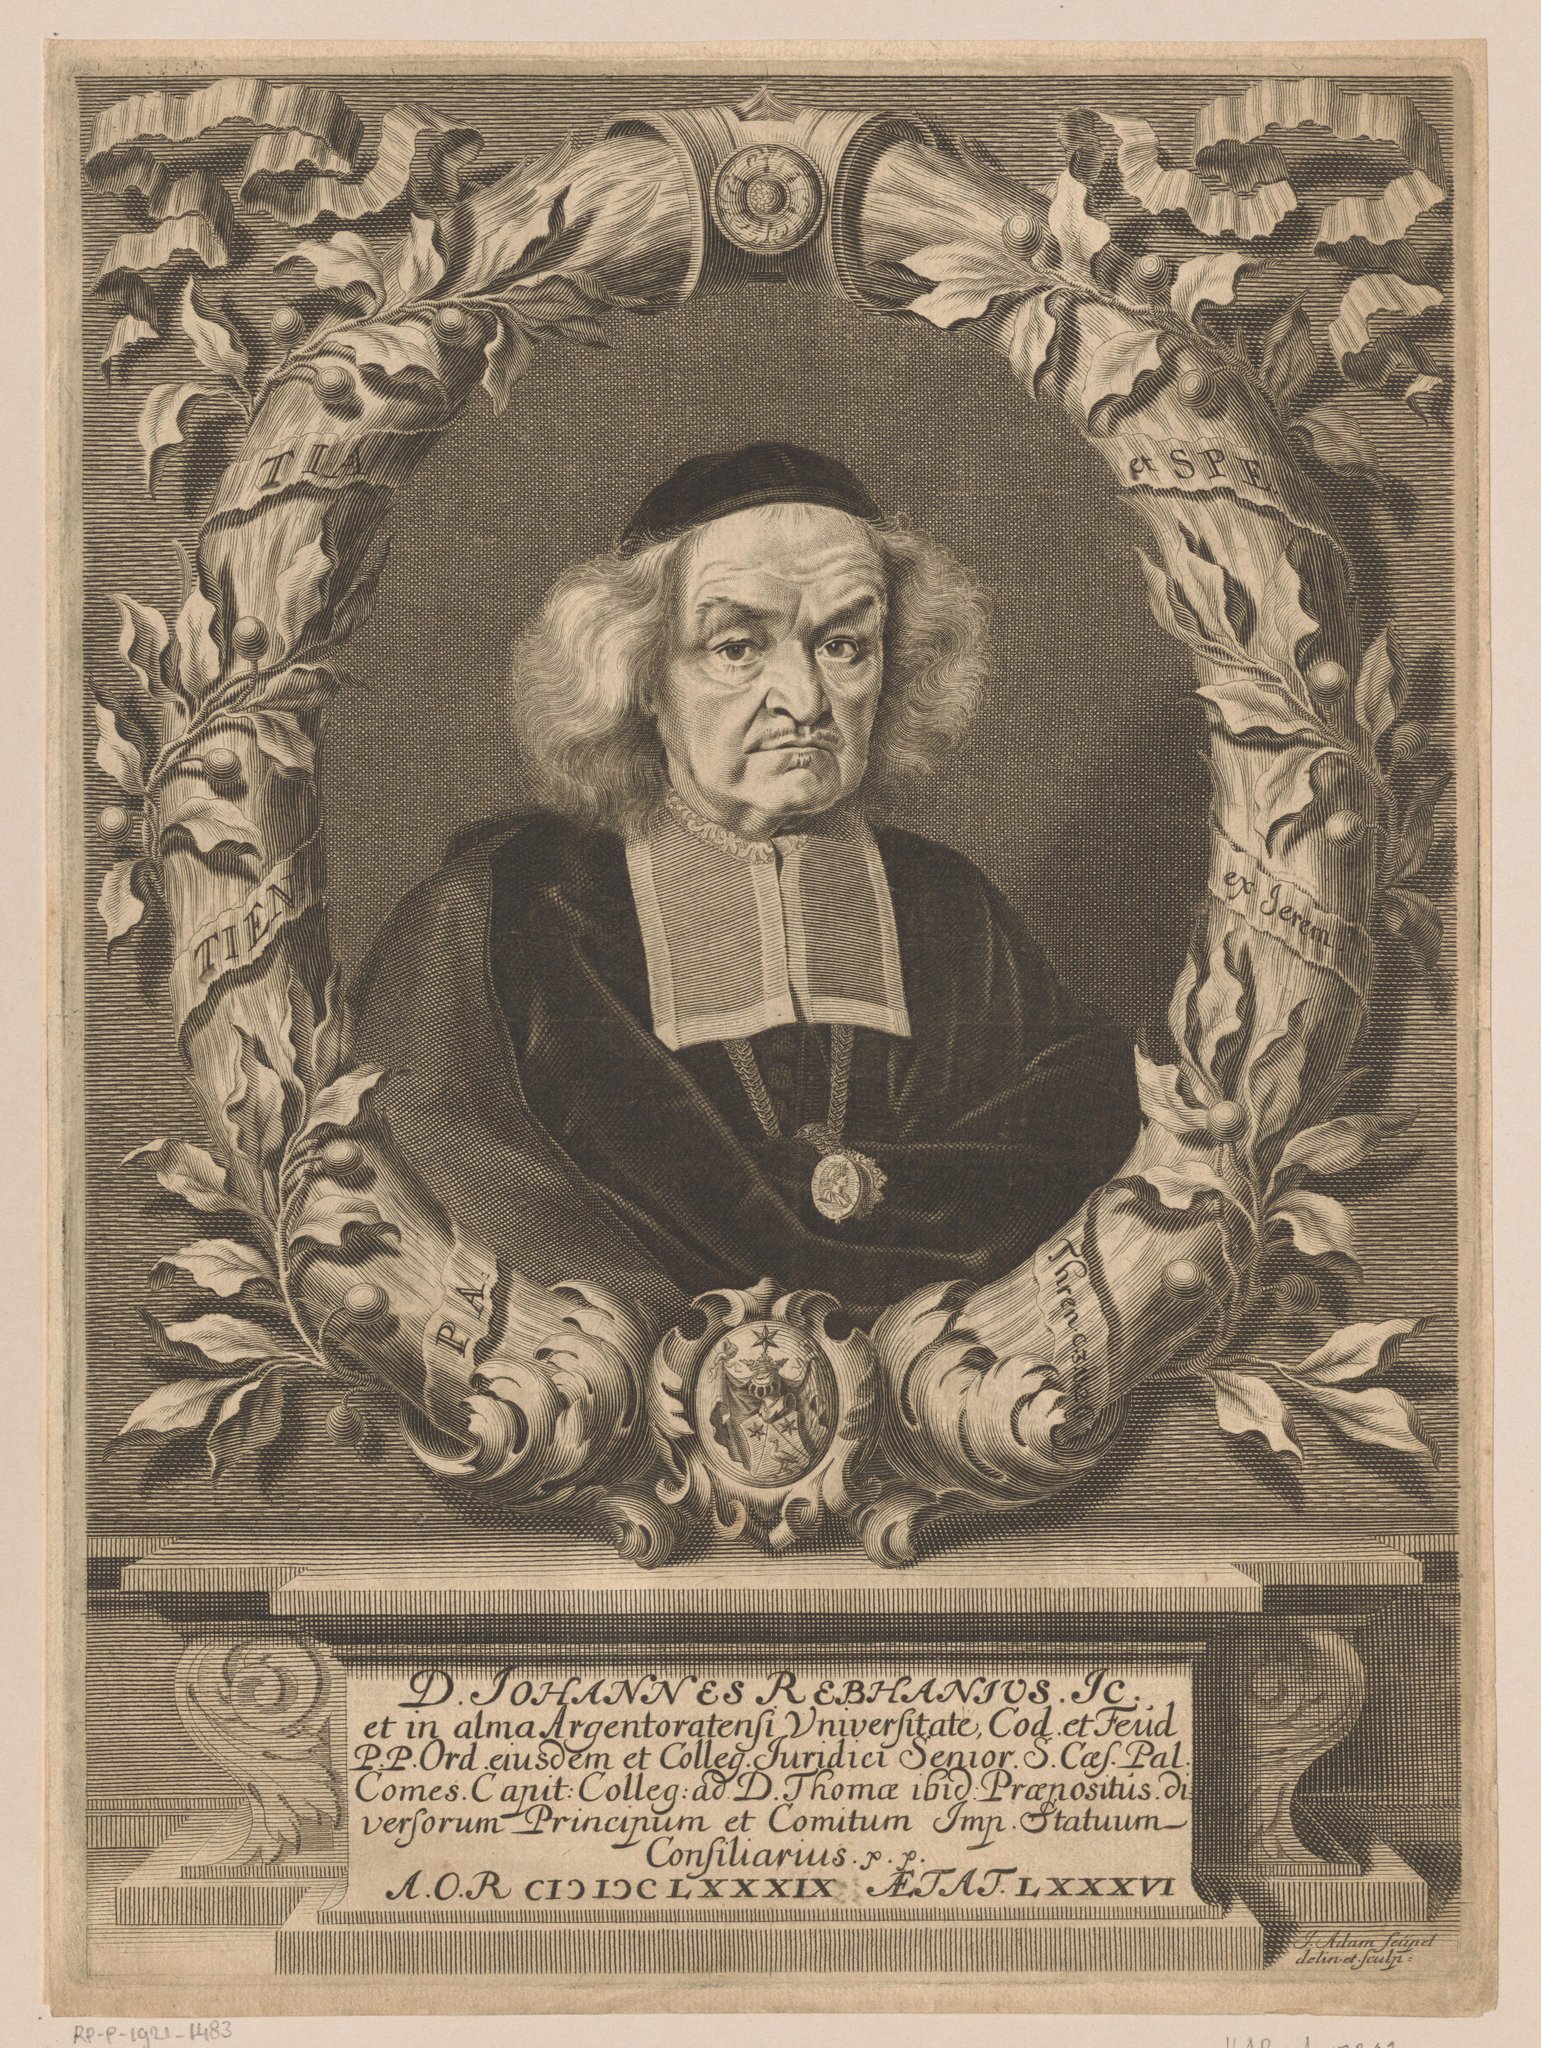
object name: print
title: Portret van Johannes Rebhan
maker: johann adam seupel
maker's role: painter, print maker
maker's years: 1662-1717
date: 1689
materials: paper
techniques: engraving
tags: johannes rebhan, historical persons, armorial bearing, heraldry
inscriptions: collector's mark: Lugt 2233